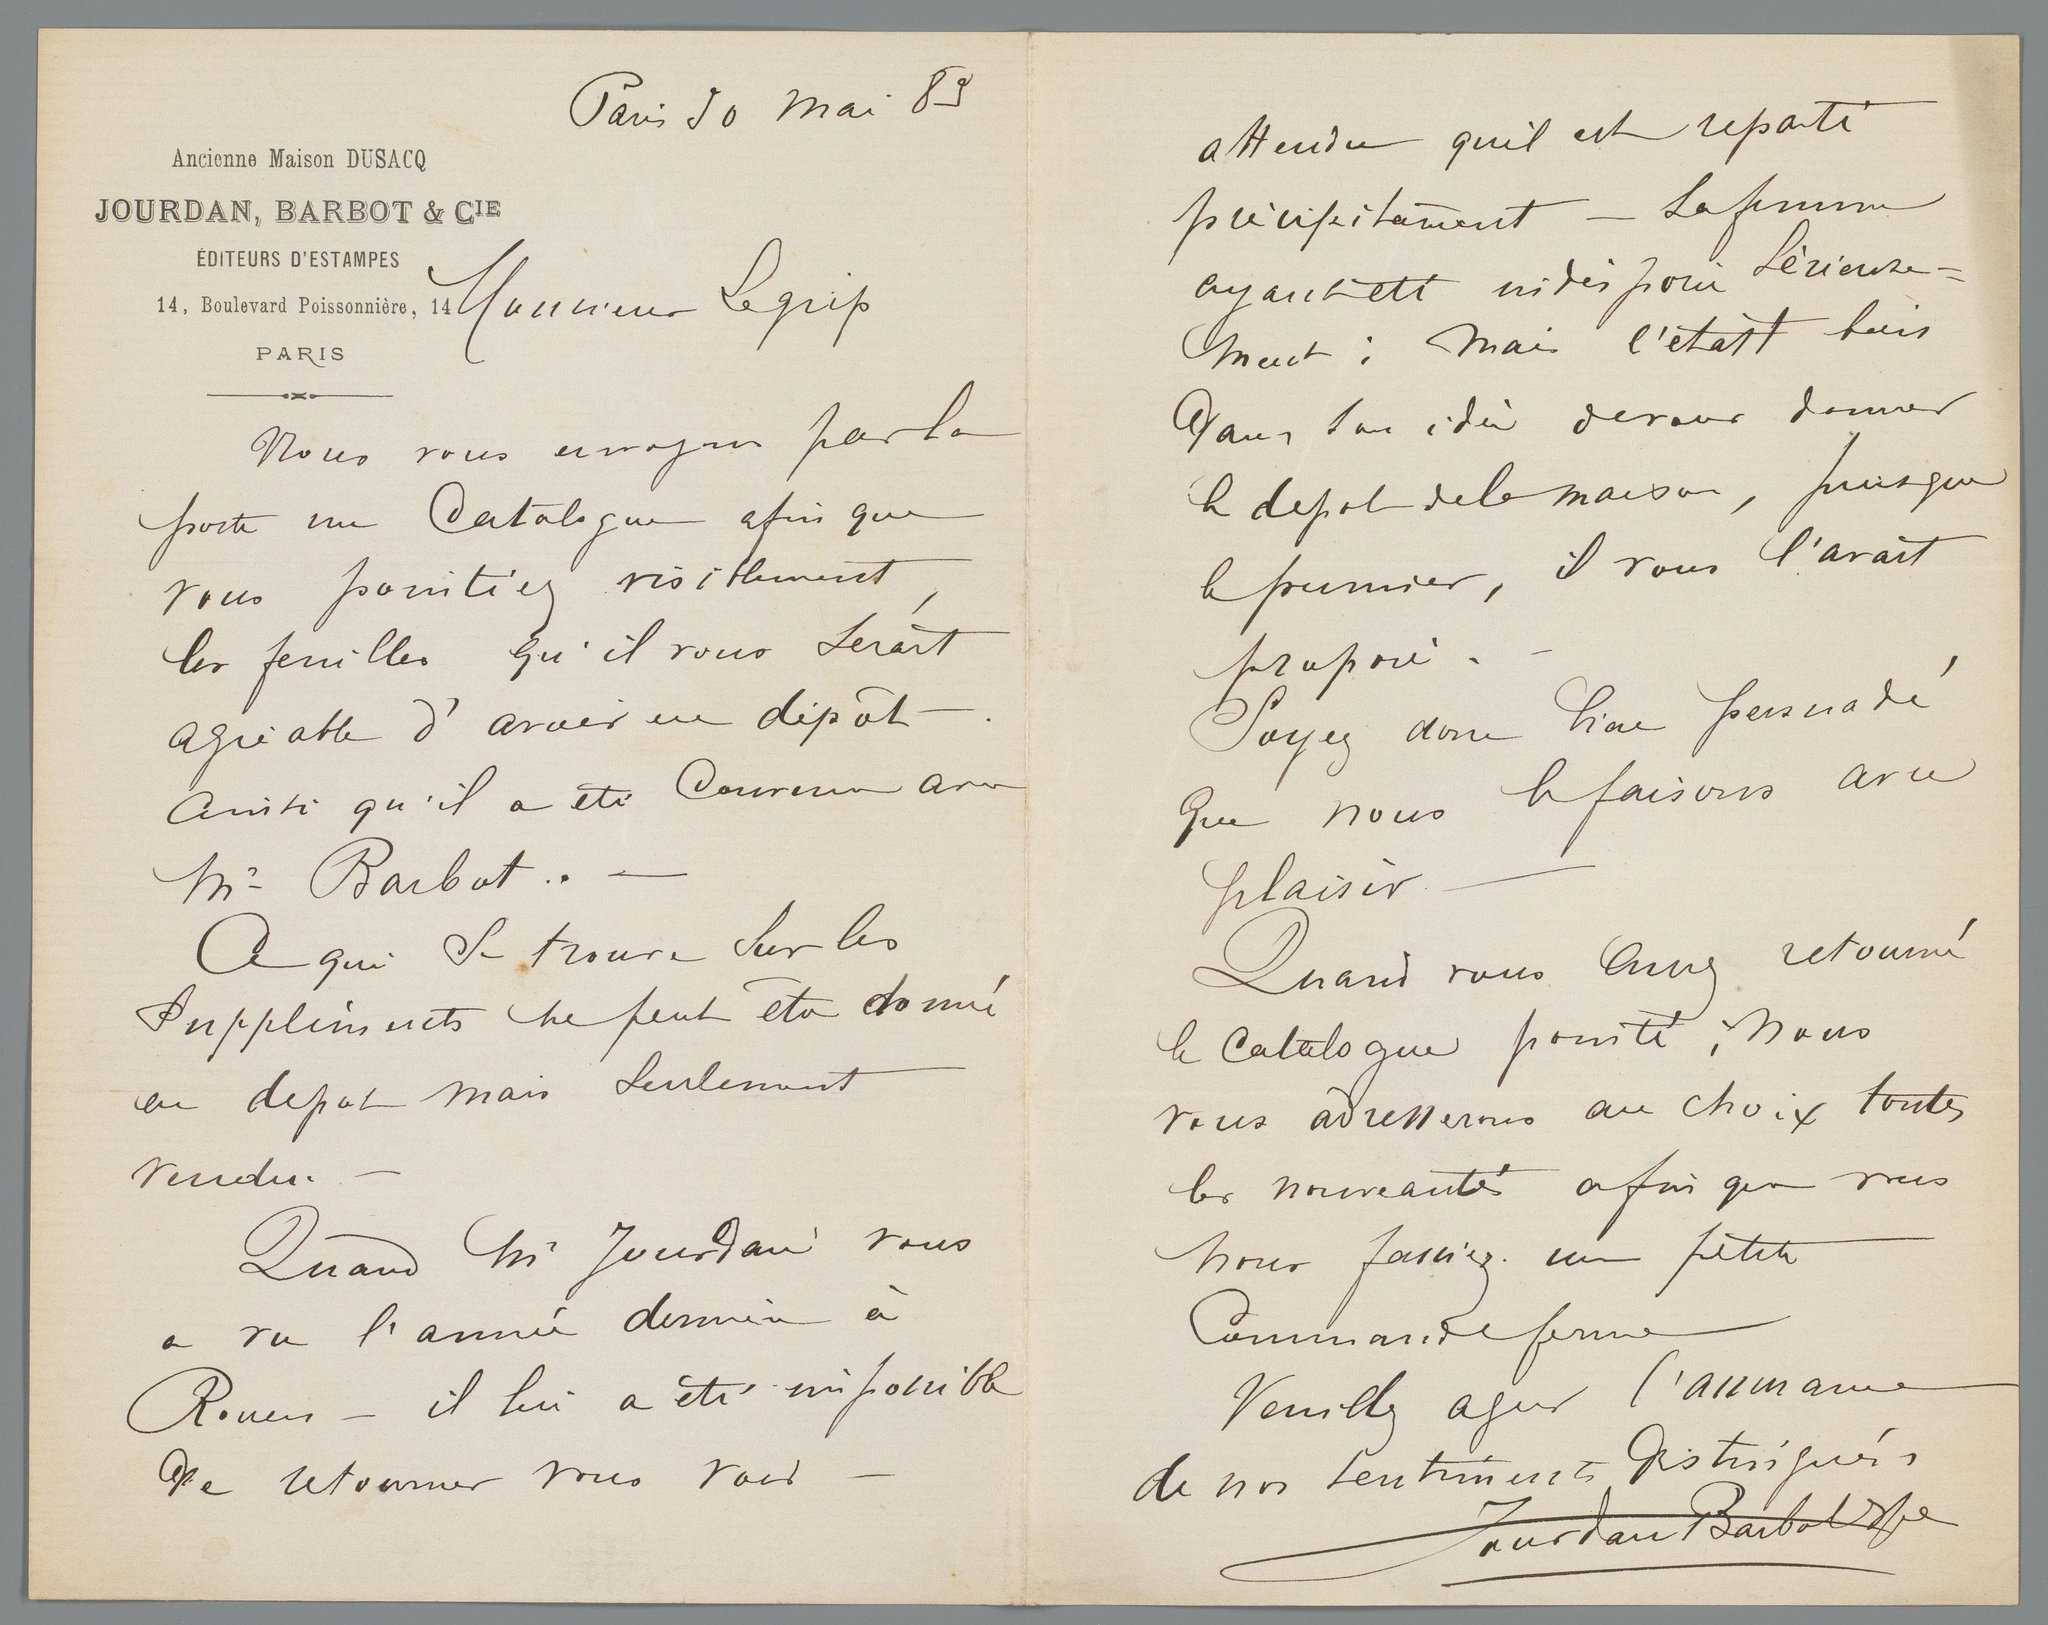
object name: letter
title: Brief van Jourdan Barbot & Cie. gericht aan de heer Legrip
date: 1889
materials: ink, paper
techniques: pen, printing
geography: paris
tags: letter, envelope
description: Brief horend bij de publicatie 'Fabrique d'appareils photographiques de tous models ... [etc] : catalogue et notice 1883, annulant les précédents', exemplaarnummer h4457.